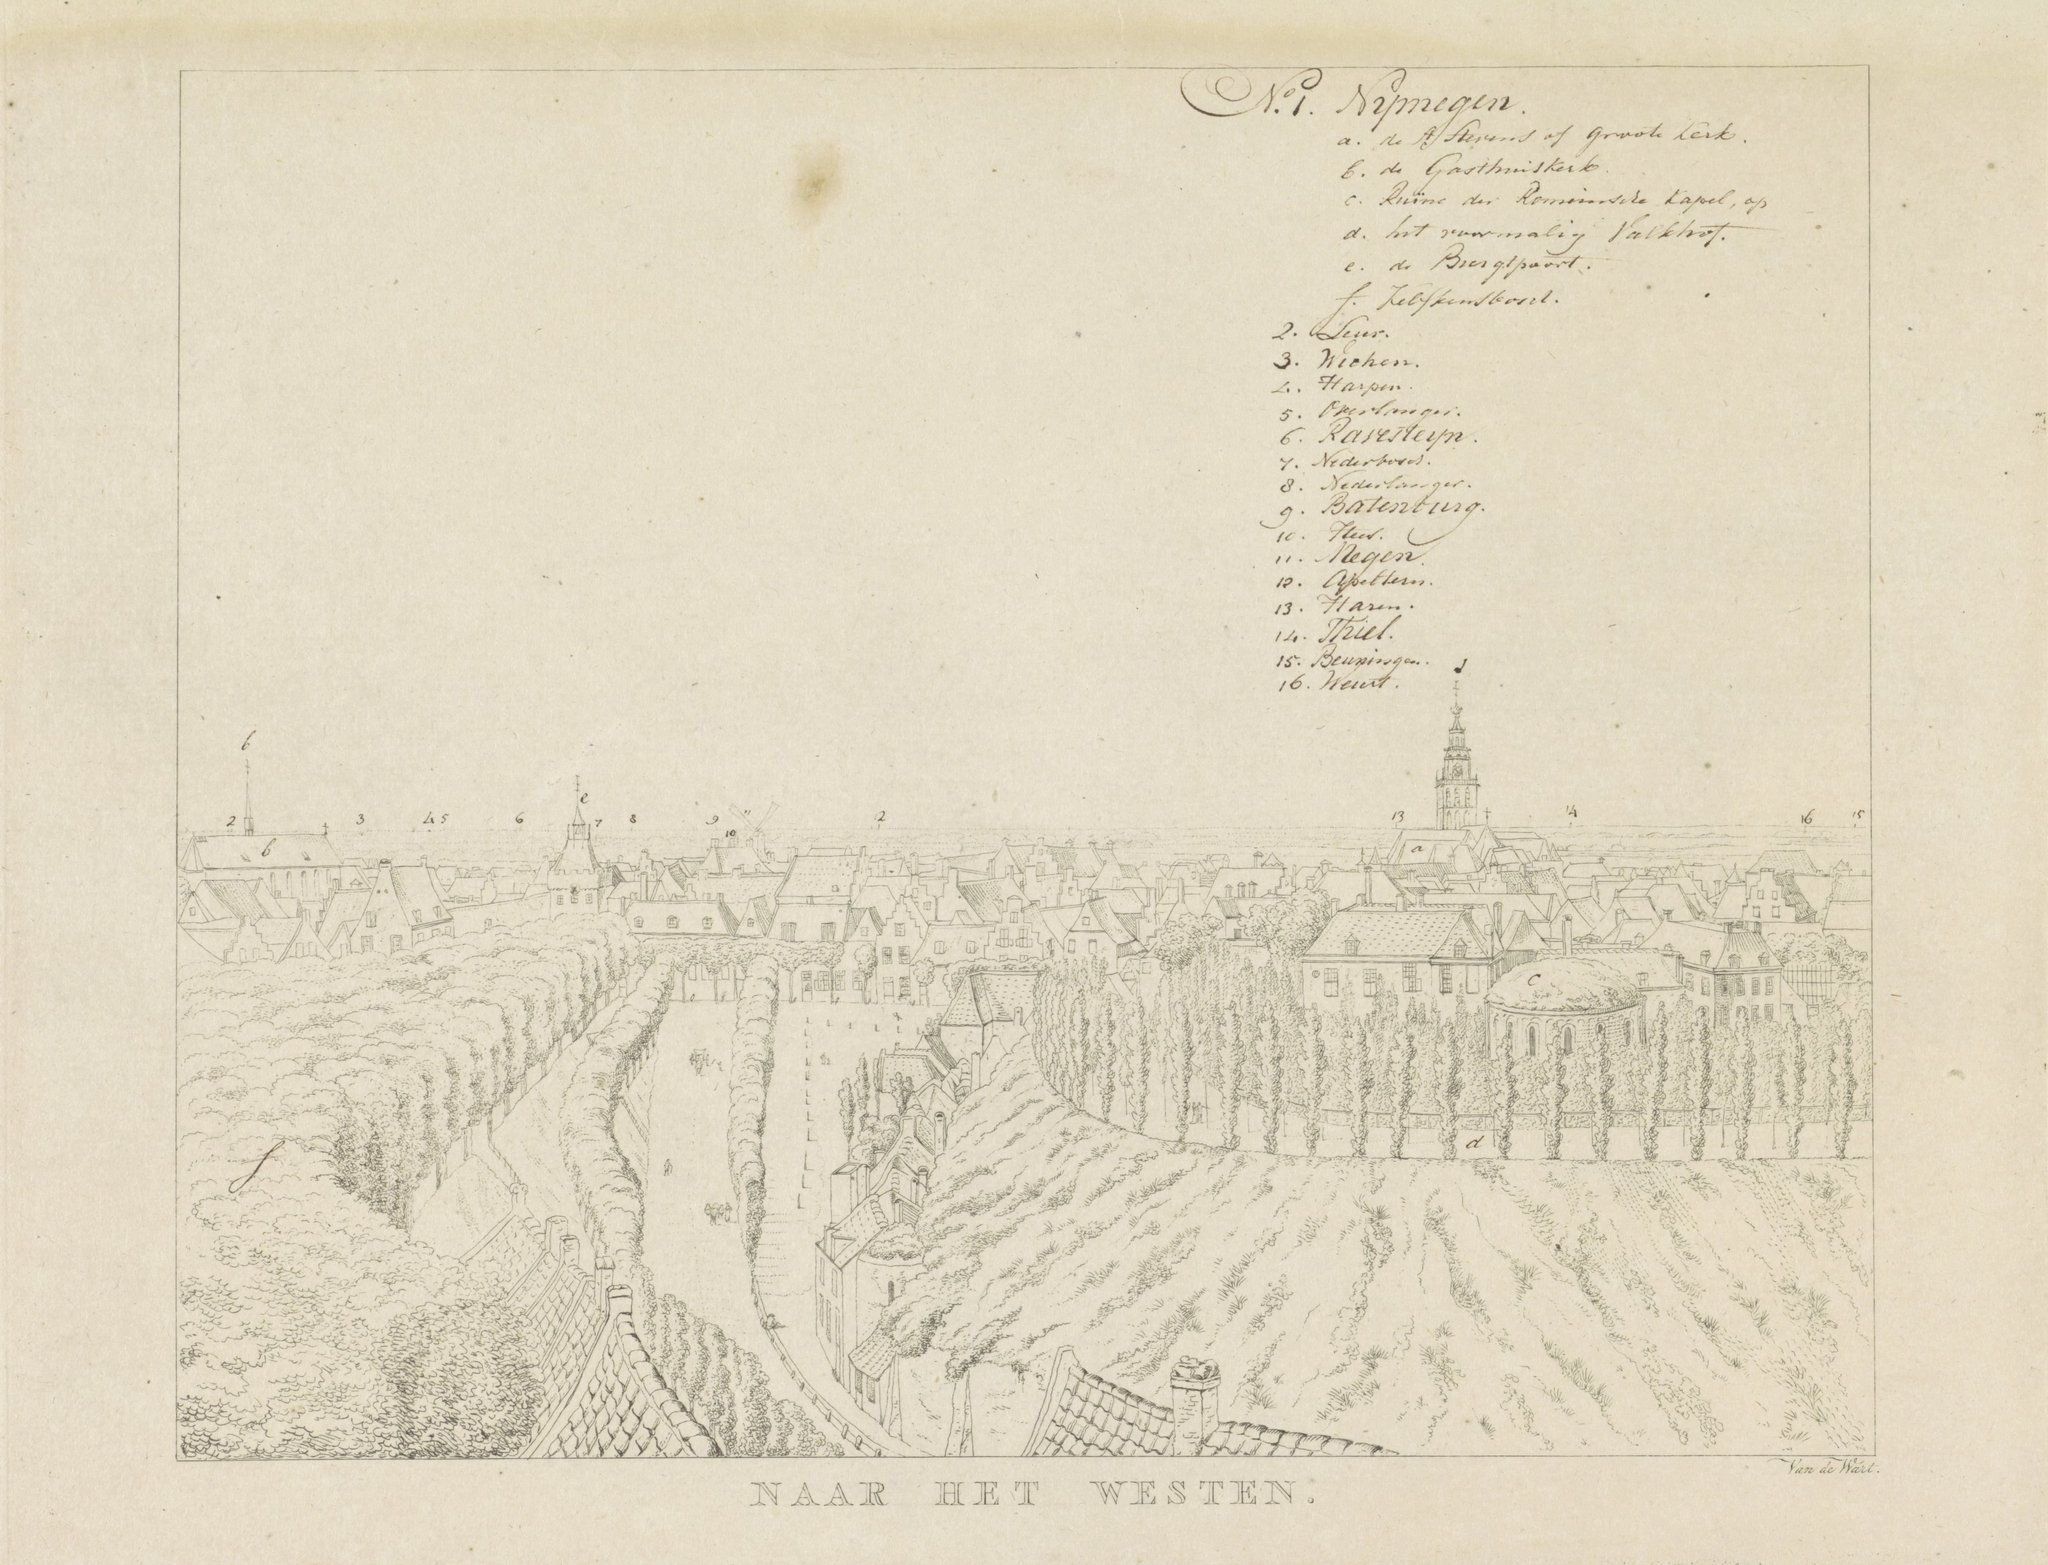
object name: print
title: Gezichten rondom de stad Nijmegen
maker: derk anthony van de wart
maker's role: draughtsman, painter, print maker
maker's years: 1767-1824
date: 1815-1824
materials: ink, paper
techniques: etching, pen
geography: nijmegen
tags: landscapes in the temperate zone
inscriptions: collector's mark: Lugt 2228, inscription: ‘No. 1. Nijmegen. a. de Stevenskerk of Groote Kerk. b. de Gasthuiskerk. c. Ruïne der Romeinse Kapel, op d. het voormalig Valkhof. e. de Burgtpoort. f. Kelfkensbosch...3. Wijchen...6. Ravenstein...14. Thiel...’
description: Het westelijk stadsdeel van Nijmegen is weergegeven met de Stevenskerk, de Gasthuiskerk, het Valkhof met de Barbarossa-ruïne, de Burchtpoort en het Kelfkensbos. Aan de horizon zijn de kerktorens van onder andere de steden Wijchen, Ravenstein en Tiel te zien. De prent is een onderdeel van een suite van negen prenten, inclusief de titelprent.